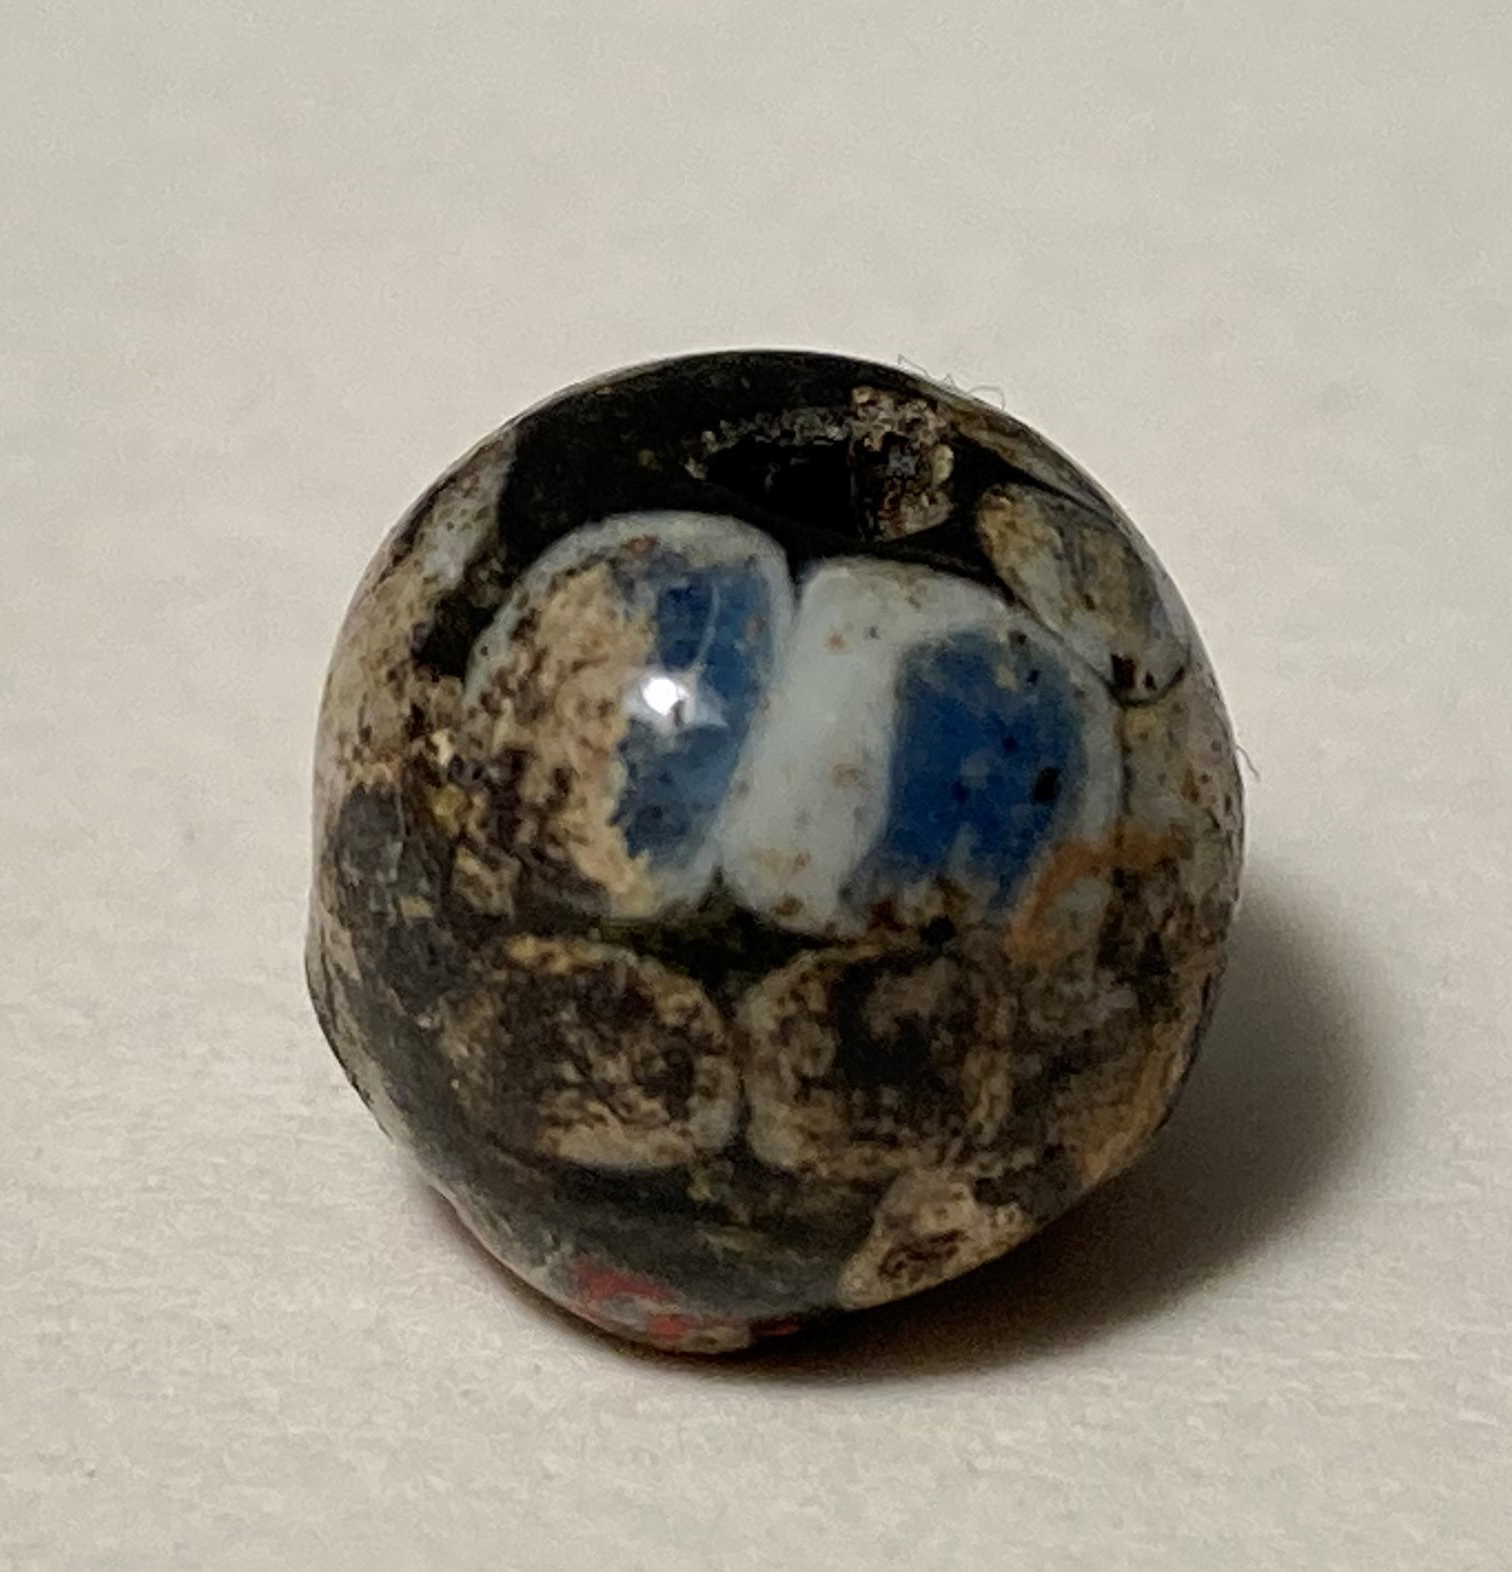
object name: bead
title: Beads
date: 701-1300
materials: glass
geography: iran